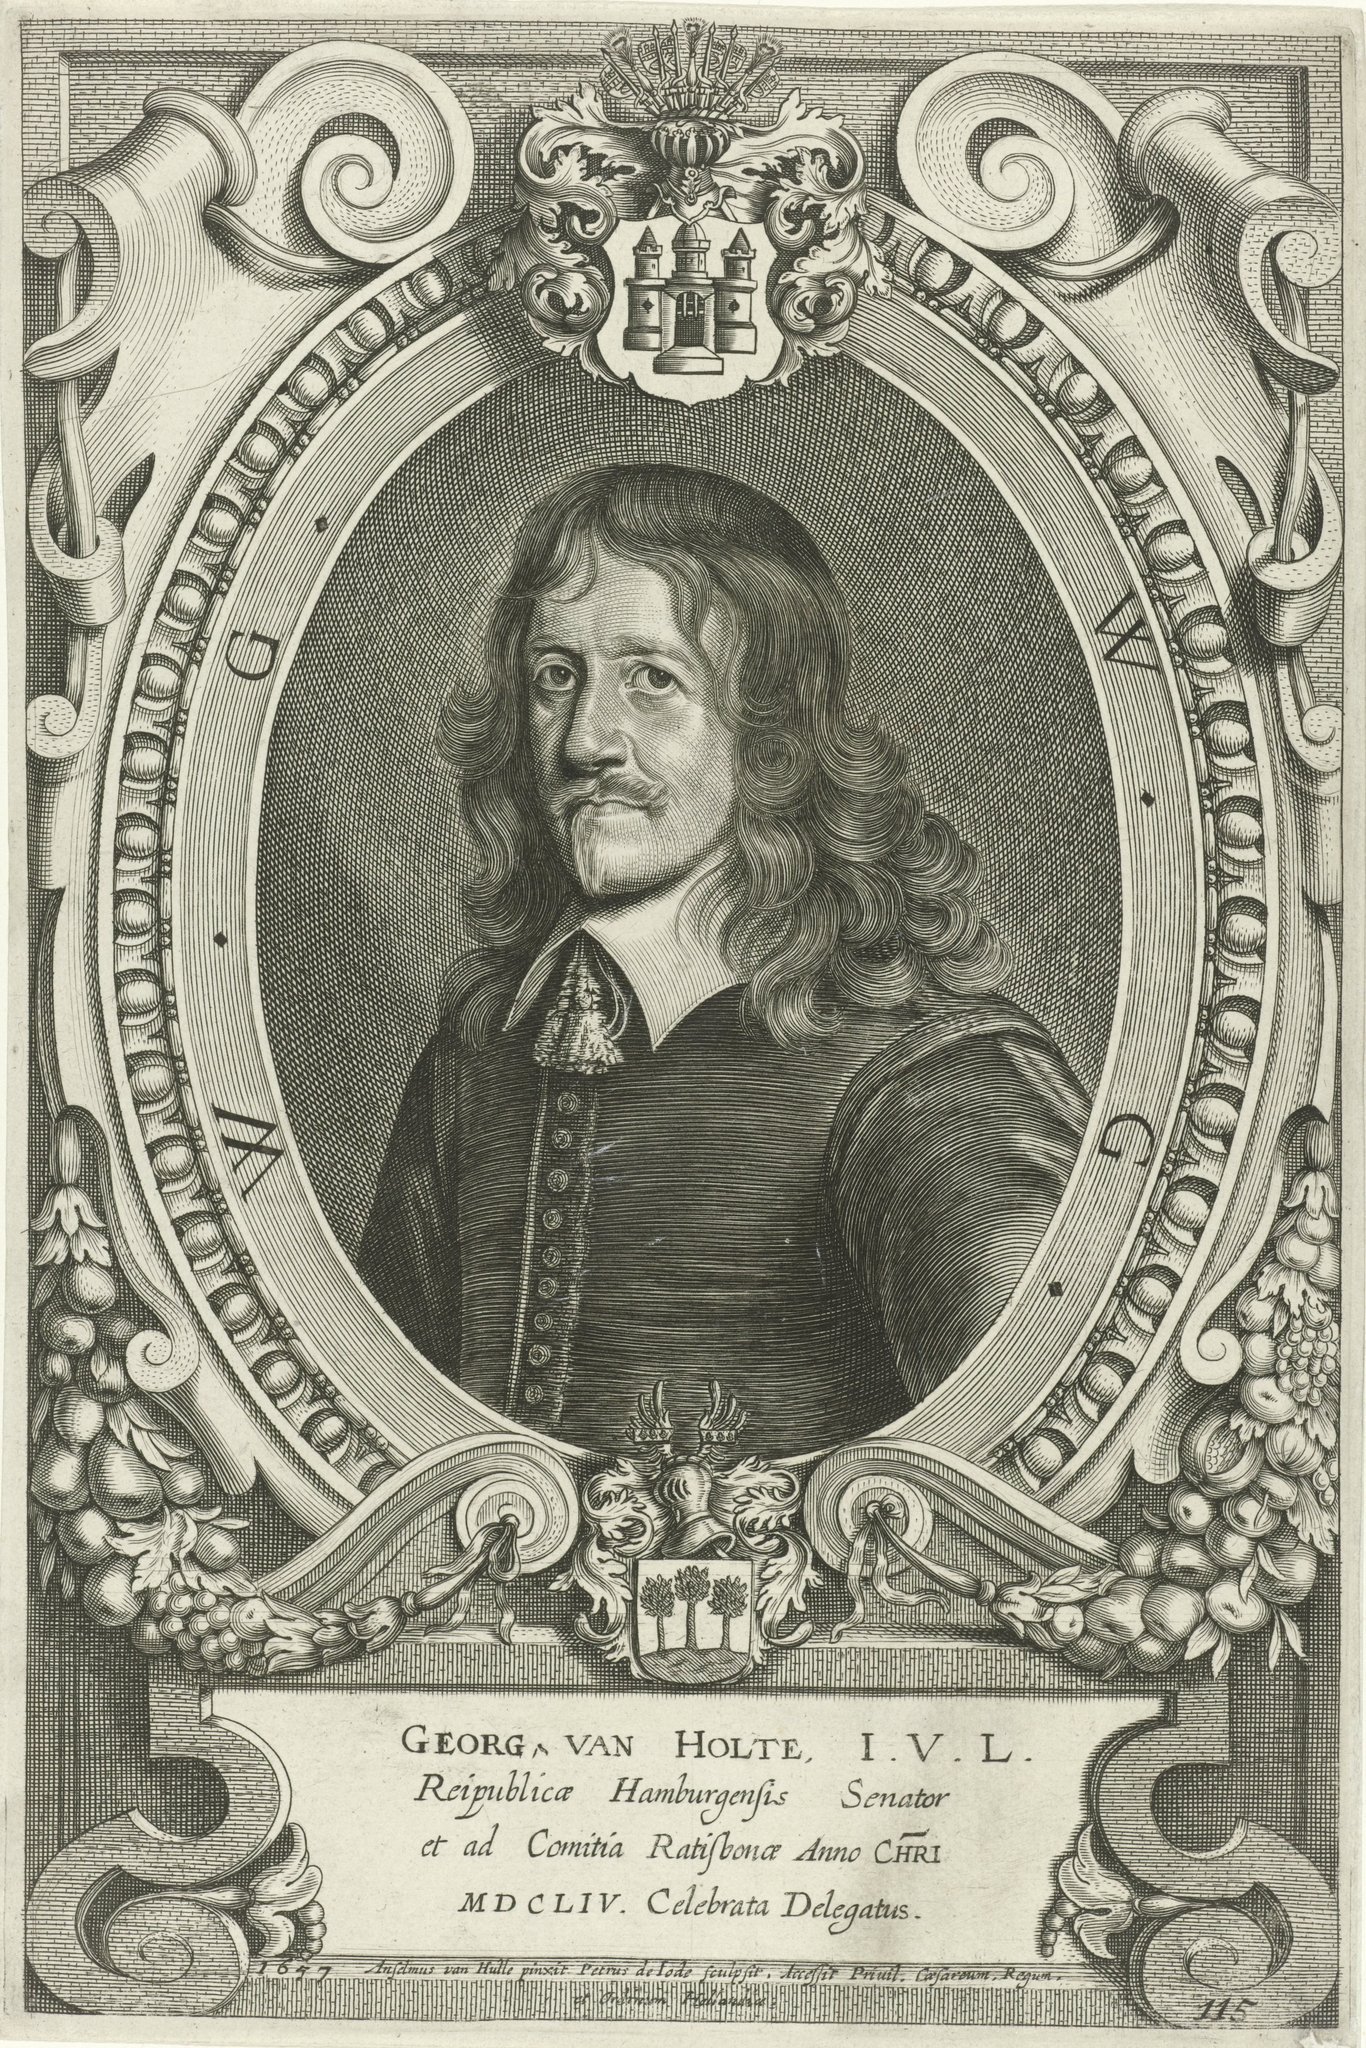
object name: print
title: Hommes illustres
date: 1657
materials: paper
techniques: engraving, etching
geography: antwerp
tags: georg van holte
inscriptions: collector's mark: Lugt 2228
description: Busteportret van Georg van Holte. Rechtsonder: 115. Het portret is gevat in een ovale omlijsting met decoraties, het wapenschild van de geportretteerde en een randschrift in het Latijn. In het kader een vierregelig onderschrift in het Latijn. Prent uit een serie portretten naar schilderijen van Anselmus van Hulle van alle gedelegeerden bij de vredesonderhandelingen te Münster en Osnabrück.